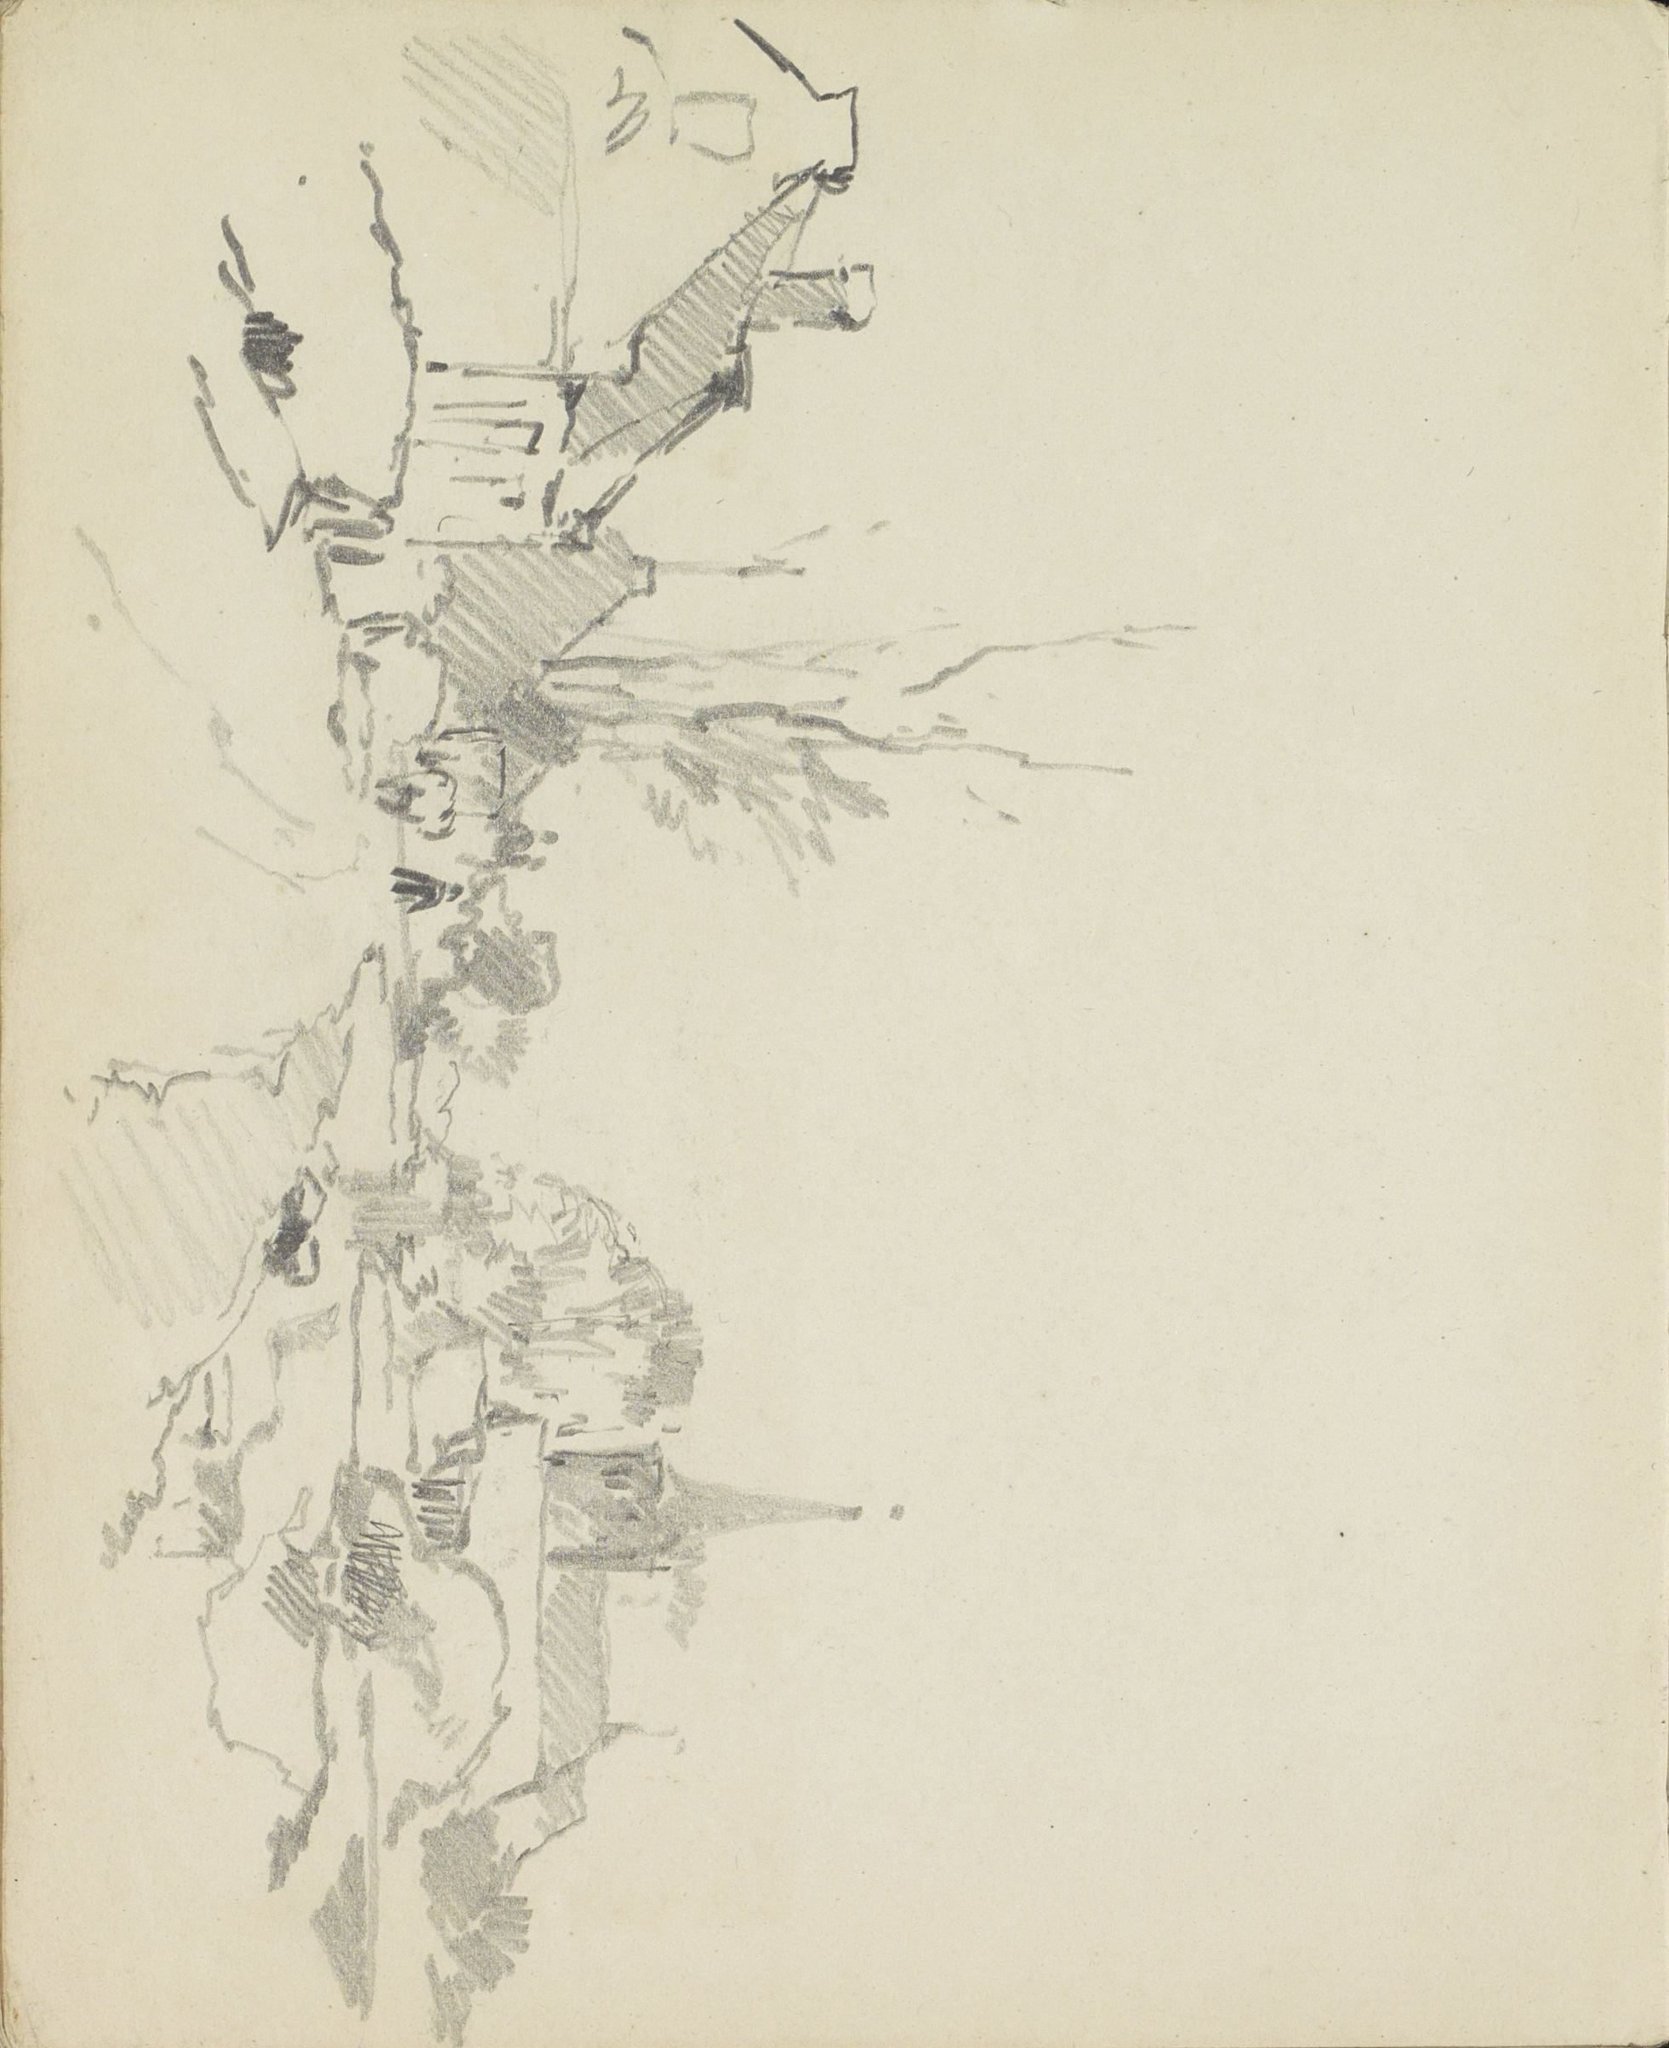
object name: sketchbook leaf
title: Figuren op een dorpsweg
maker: cornelis vreedenburgh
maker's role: draughtsman, print maker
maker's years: 1880-1946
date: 1890-1946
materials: paper, pencil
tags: village street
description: Blad 74 verso uit een schetsboek met 76 bladen.